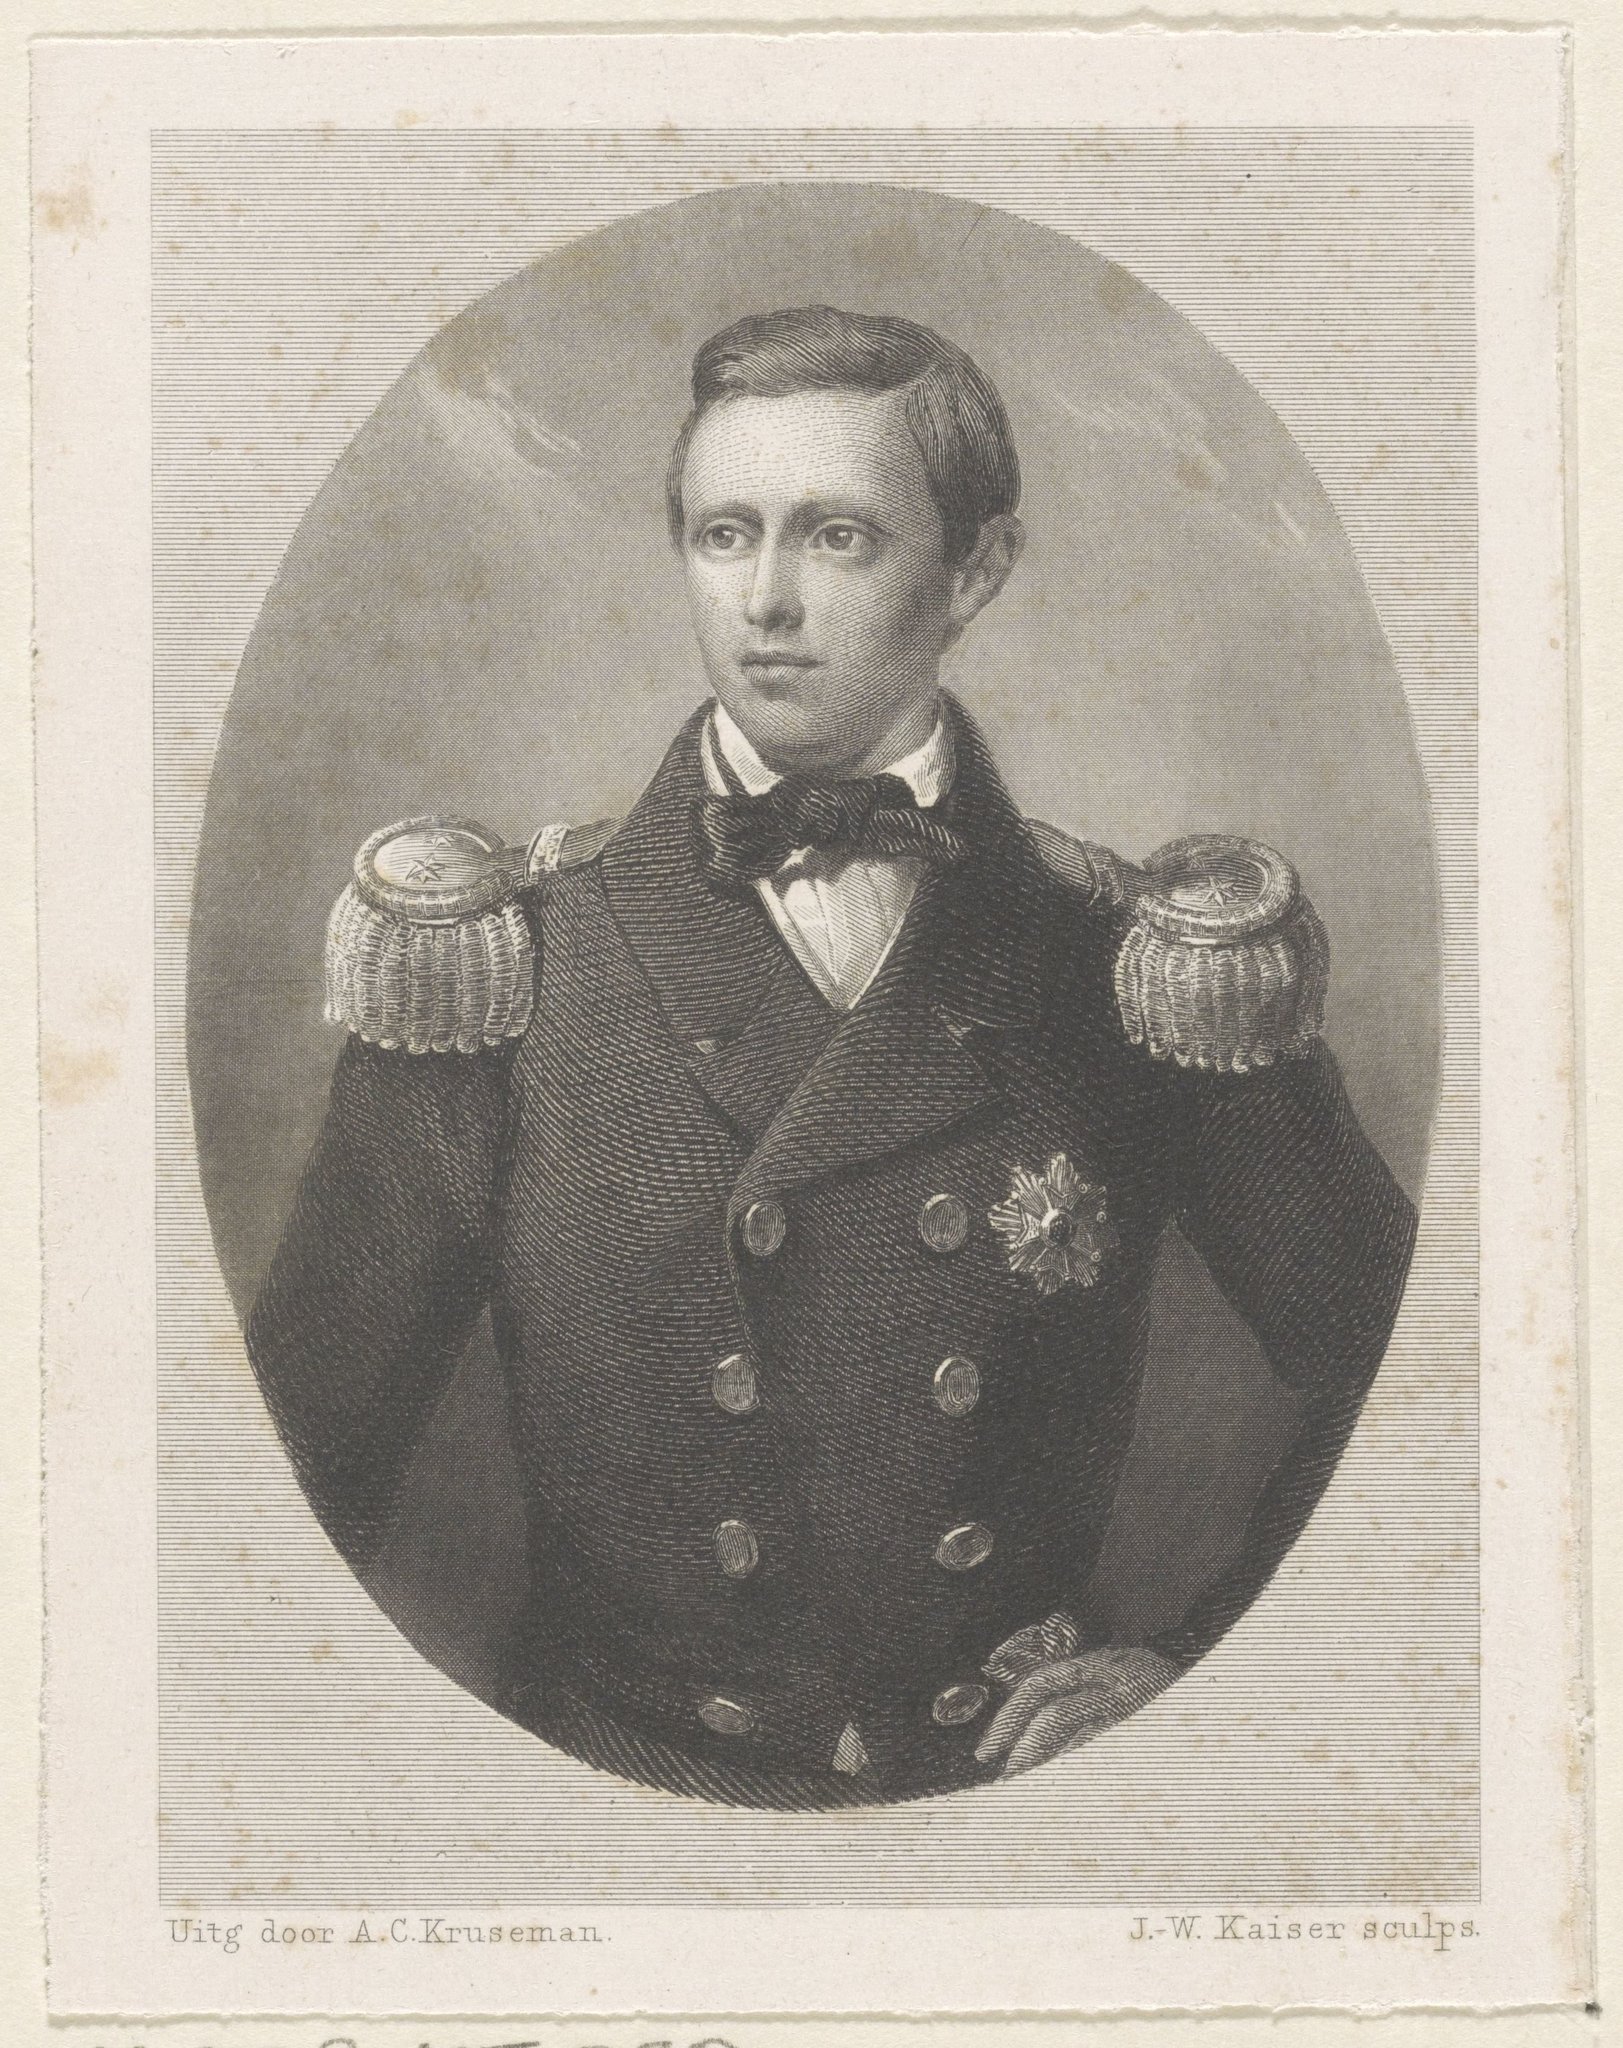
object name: print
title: Portret van Willem, prins der Nederlanden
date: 1850-1894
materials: paper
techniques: engraving, etching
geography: haarlem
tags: paris, willem (prins der nederlanden)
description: De hier vermelde titel verwijst naar de hoogst verkregen titel van de geportretteerde, niet per se naar de titel die de geportretteerde op deze voorstelling draagt.